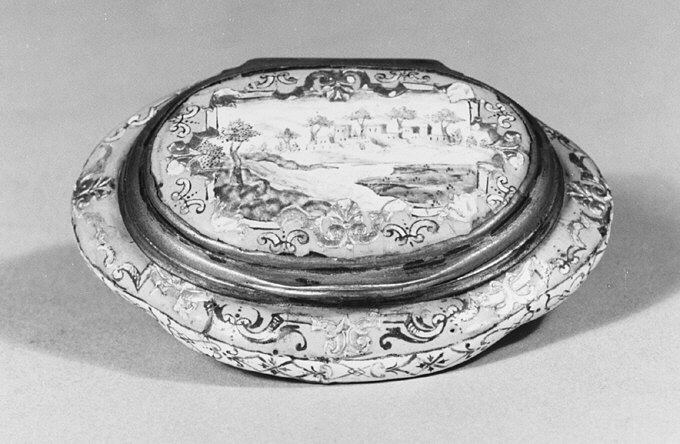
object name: snuffbox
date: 1730-1740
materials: copper, enamel, gilt, silver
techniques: painting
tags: houses,trees